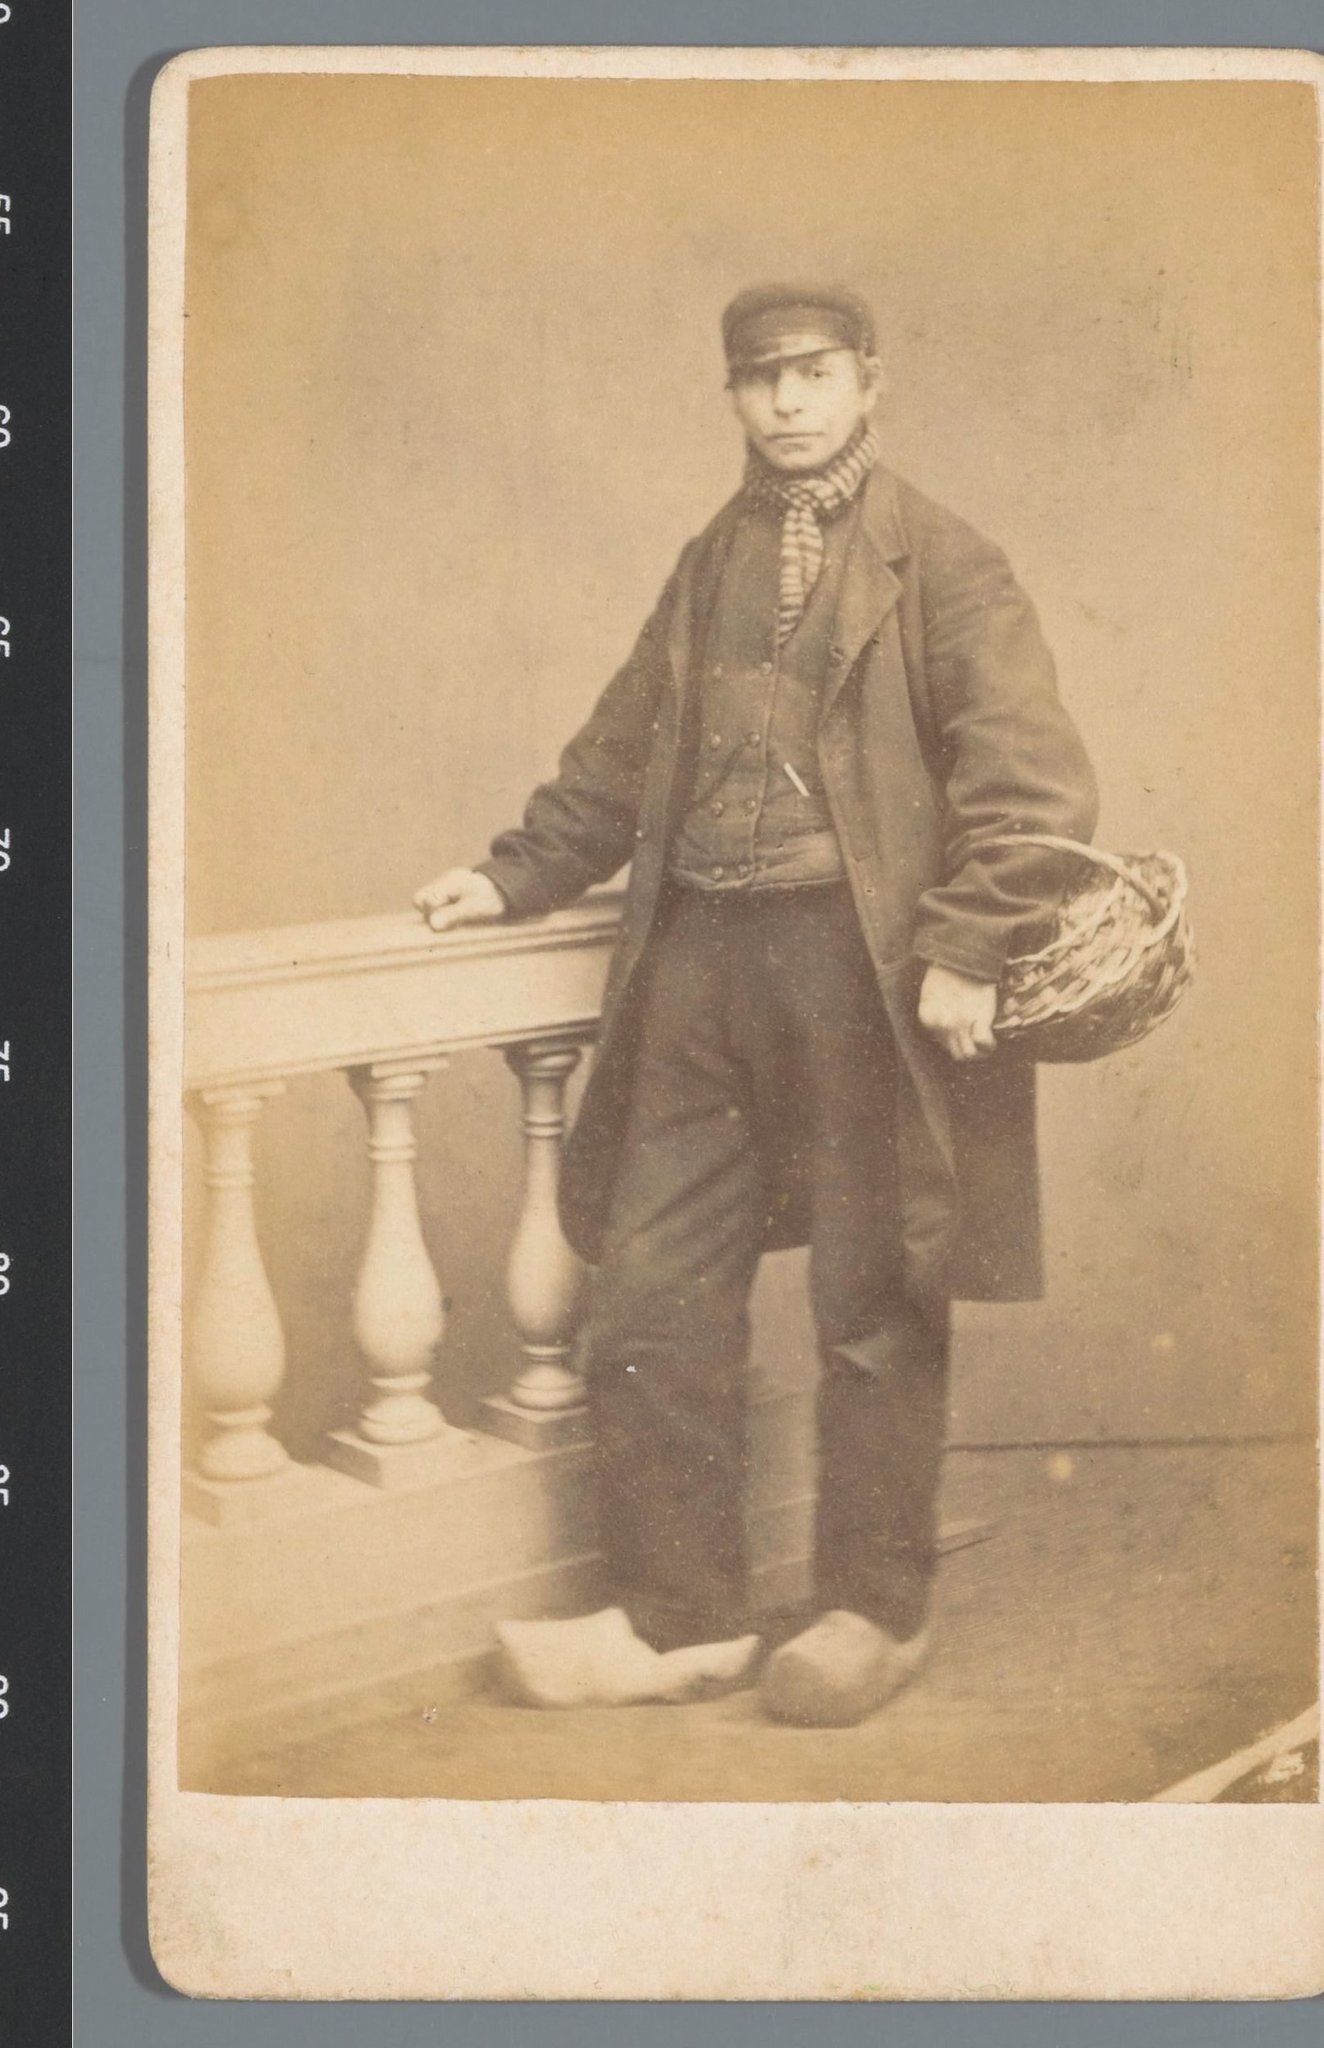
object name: photograph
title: Cartes-de-visite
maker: jan breebaard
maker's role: fotograaf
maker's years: 1835-1893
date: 1864-1869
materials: cardboard, paper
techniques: albumen print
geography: zaandijk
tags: wooden shoes, clogs, adult man, historical persons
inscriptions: inscription: ‘J. v.d. Kaar’, inscription: ‘JB/ J. L. Breebaard/ Photograph/ ZAANDIJK.’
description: Cartomanie was a collecting craze. From 1855 hundreds of thousands of these portraits were annually sold worldwide. People had photographs taken of their loved ones, including their pets, and kept them in an album. Portraits of kings, writers, artists, actors, and statesmen were also collected. Photography was no longer the preserve of the wealthy; farmers and maidservants now also stood before the camera.